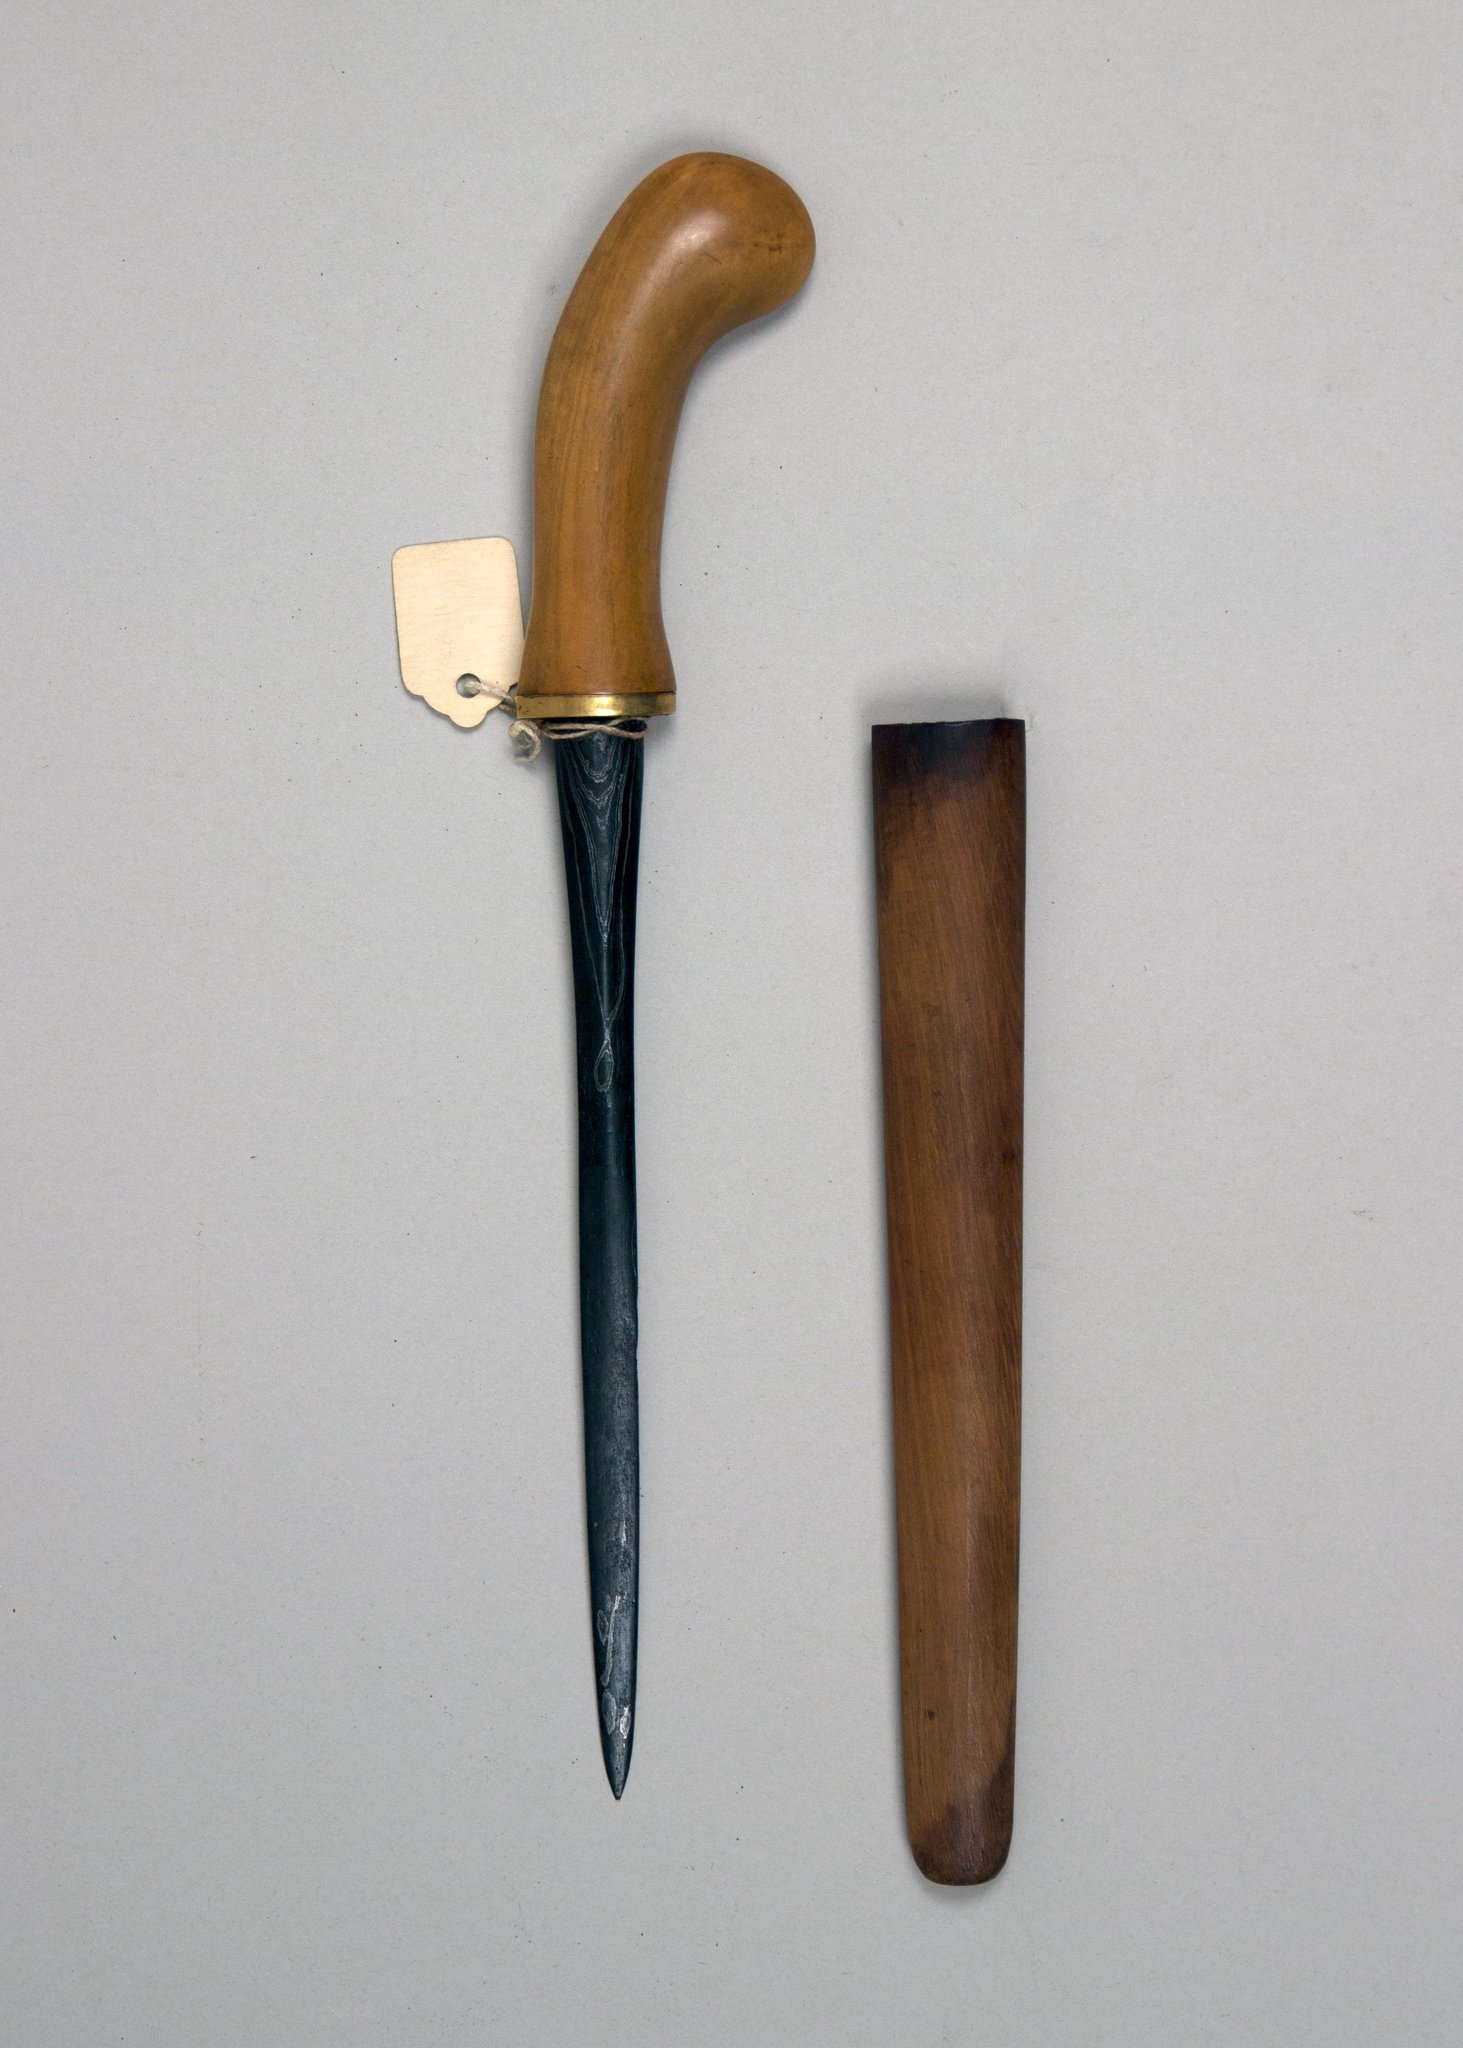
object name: knife with sheath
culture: javanese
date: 1501-1900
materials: steel, wood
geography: indonesia